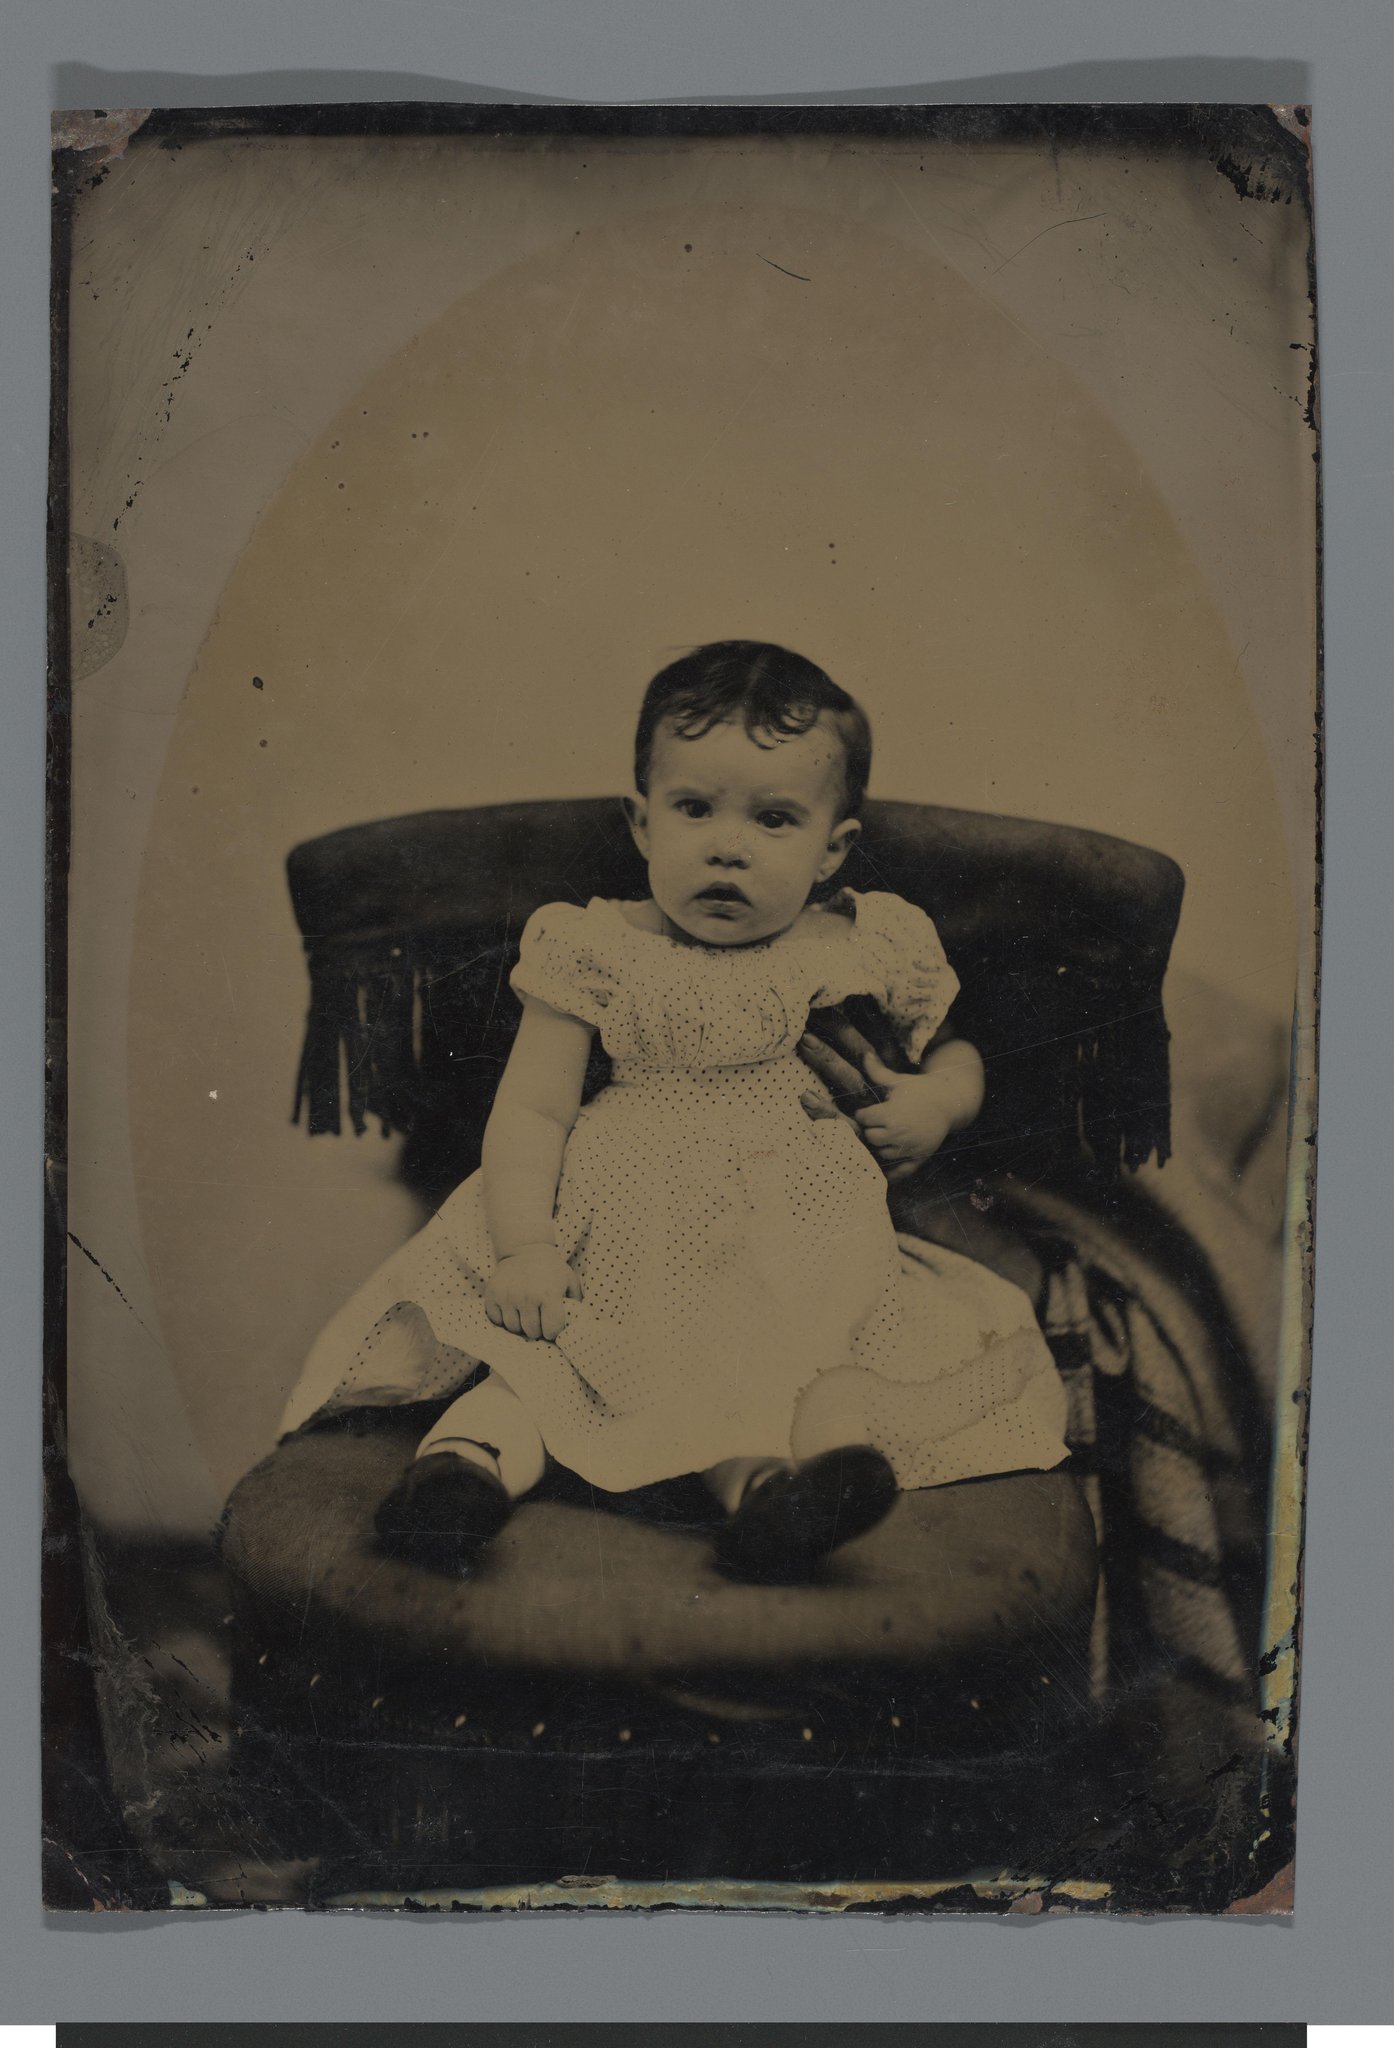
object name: photobook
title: Vrouw met baby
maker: Anonymous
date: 1870-1910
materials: photographic support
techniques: ferrotyping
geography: united states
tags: united states of america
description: Peuter op stoel vastgehouden door Zwarte hand.